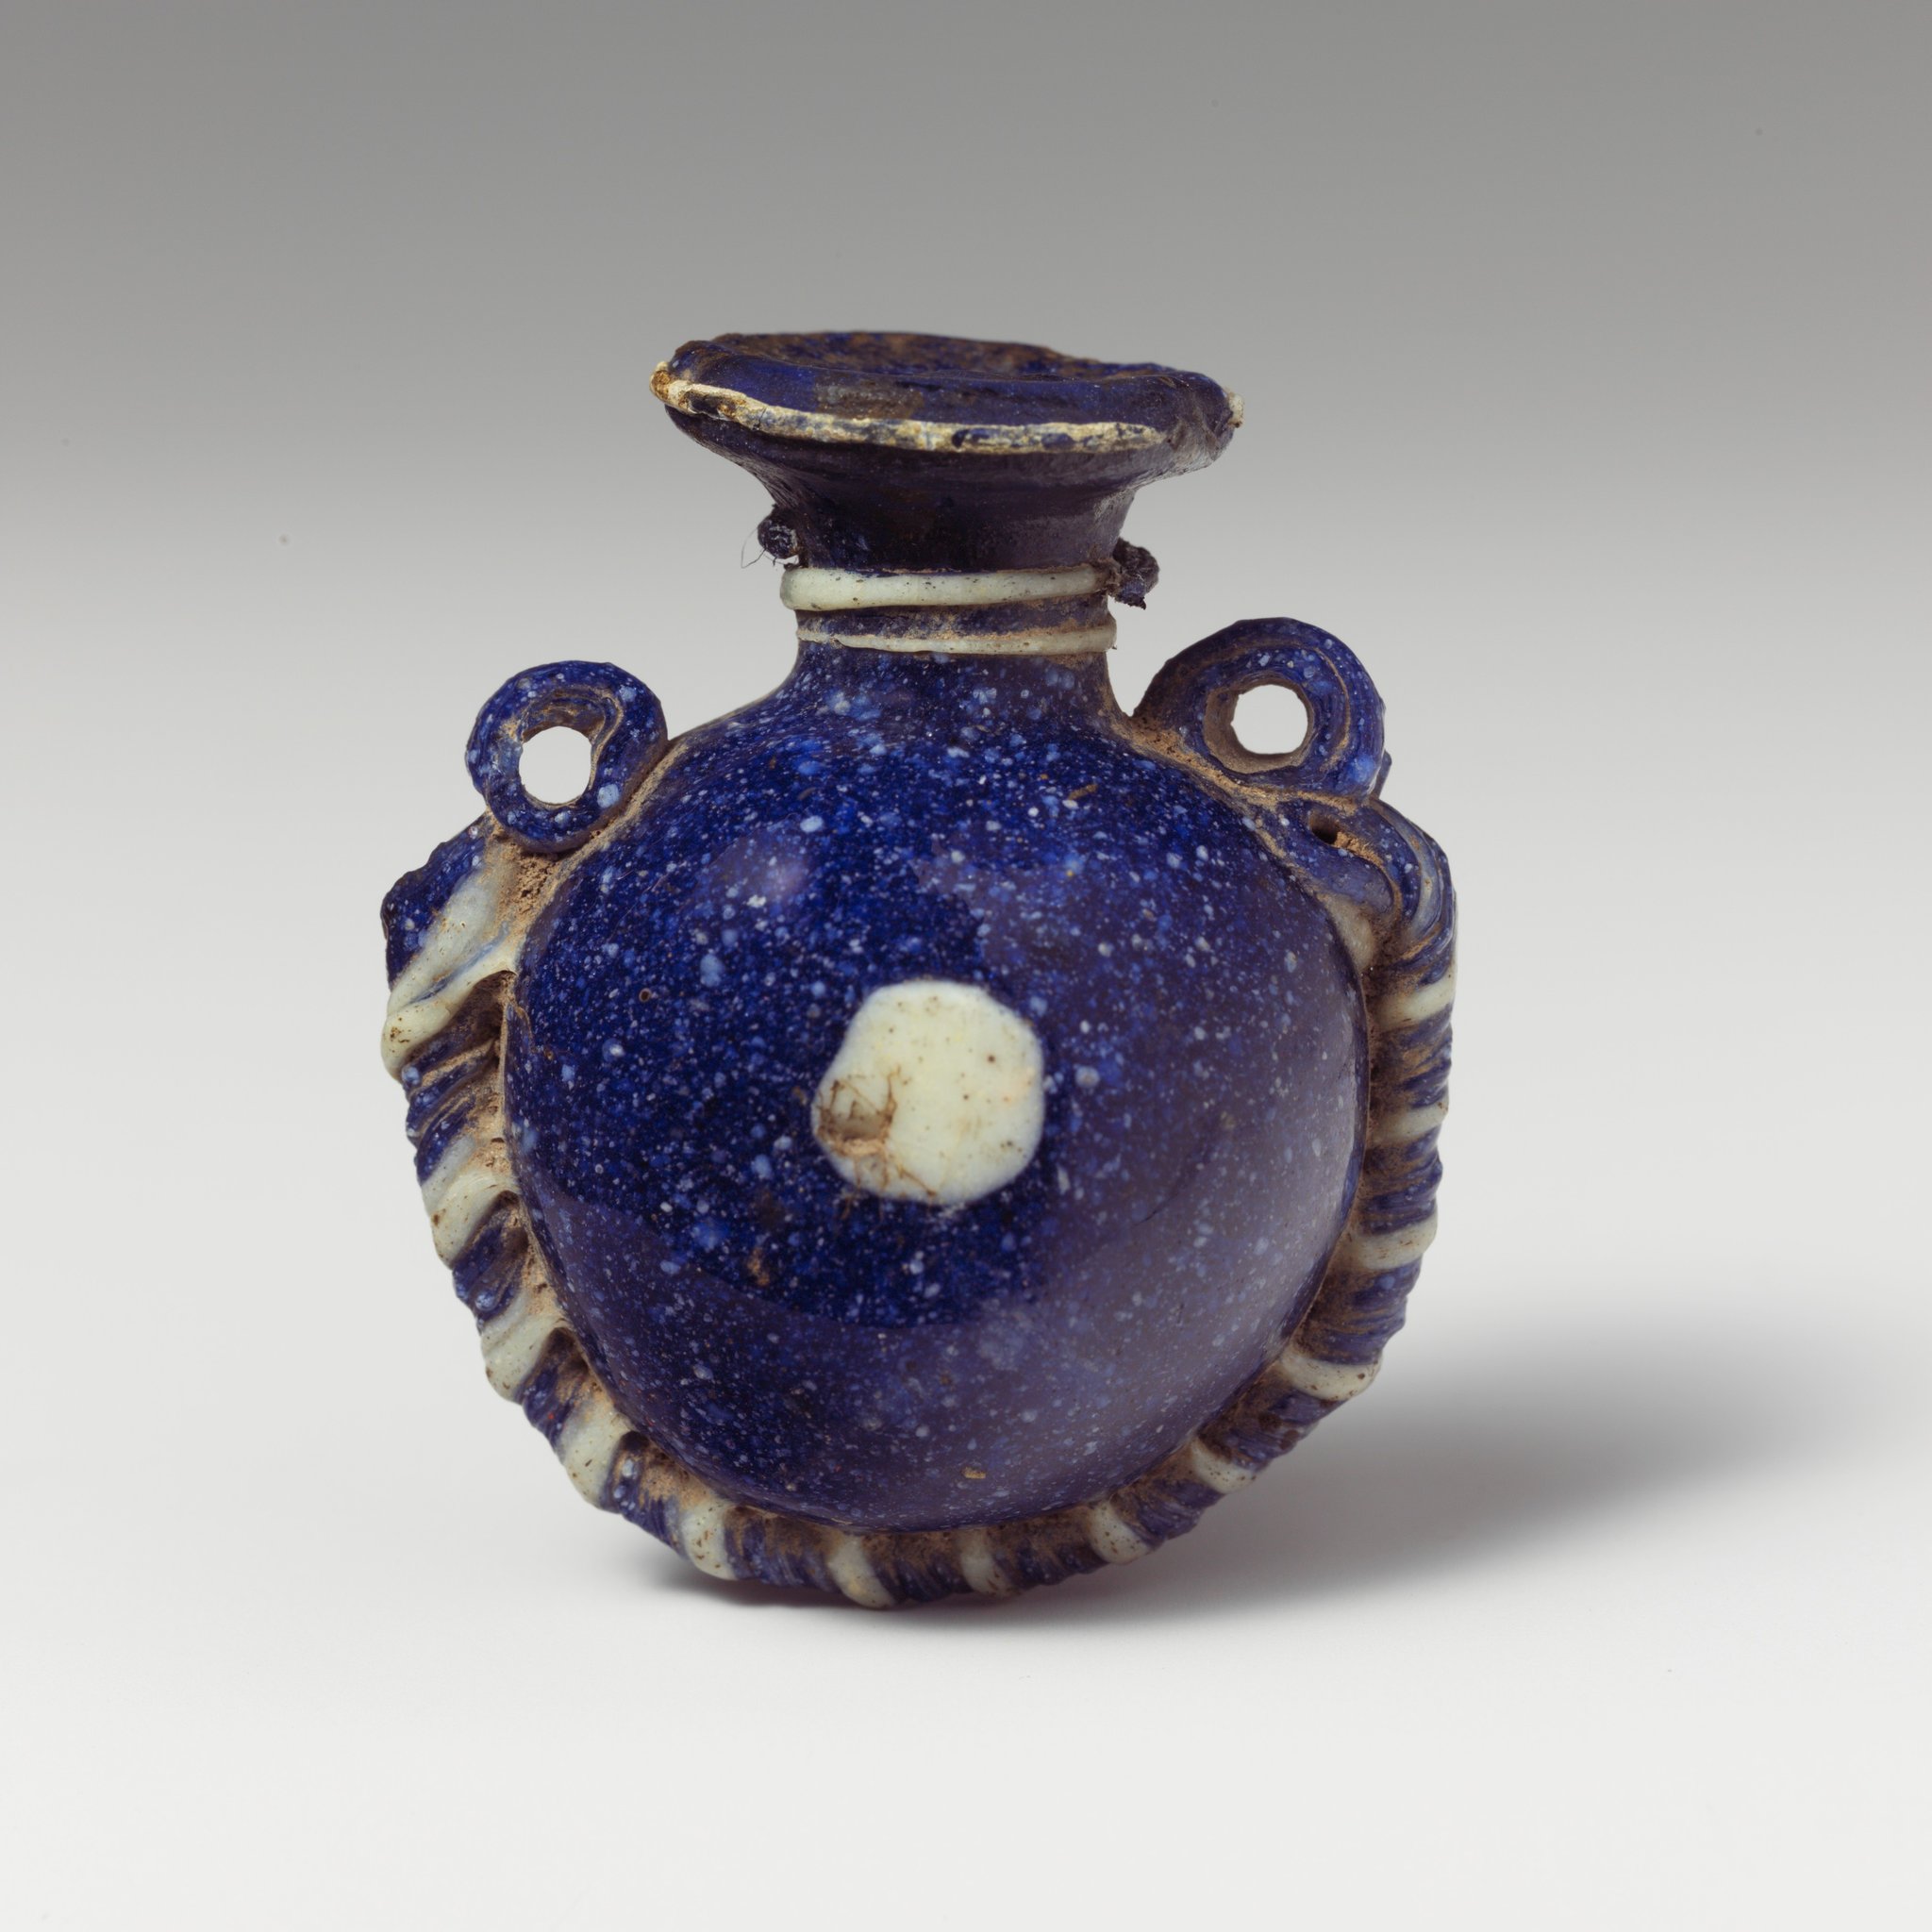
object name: aryballos, lentoid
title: Glass lentoid aryballos (perfume bottle)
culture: greek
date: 400-201 BCE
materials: glass